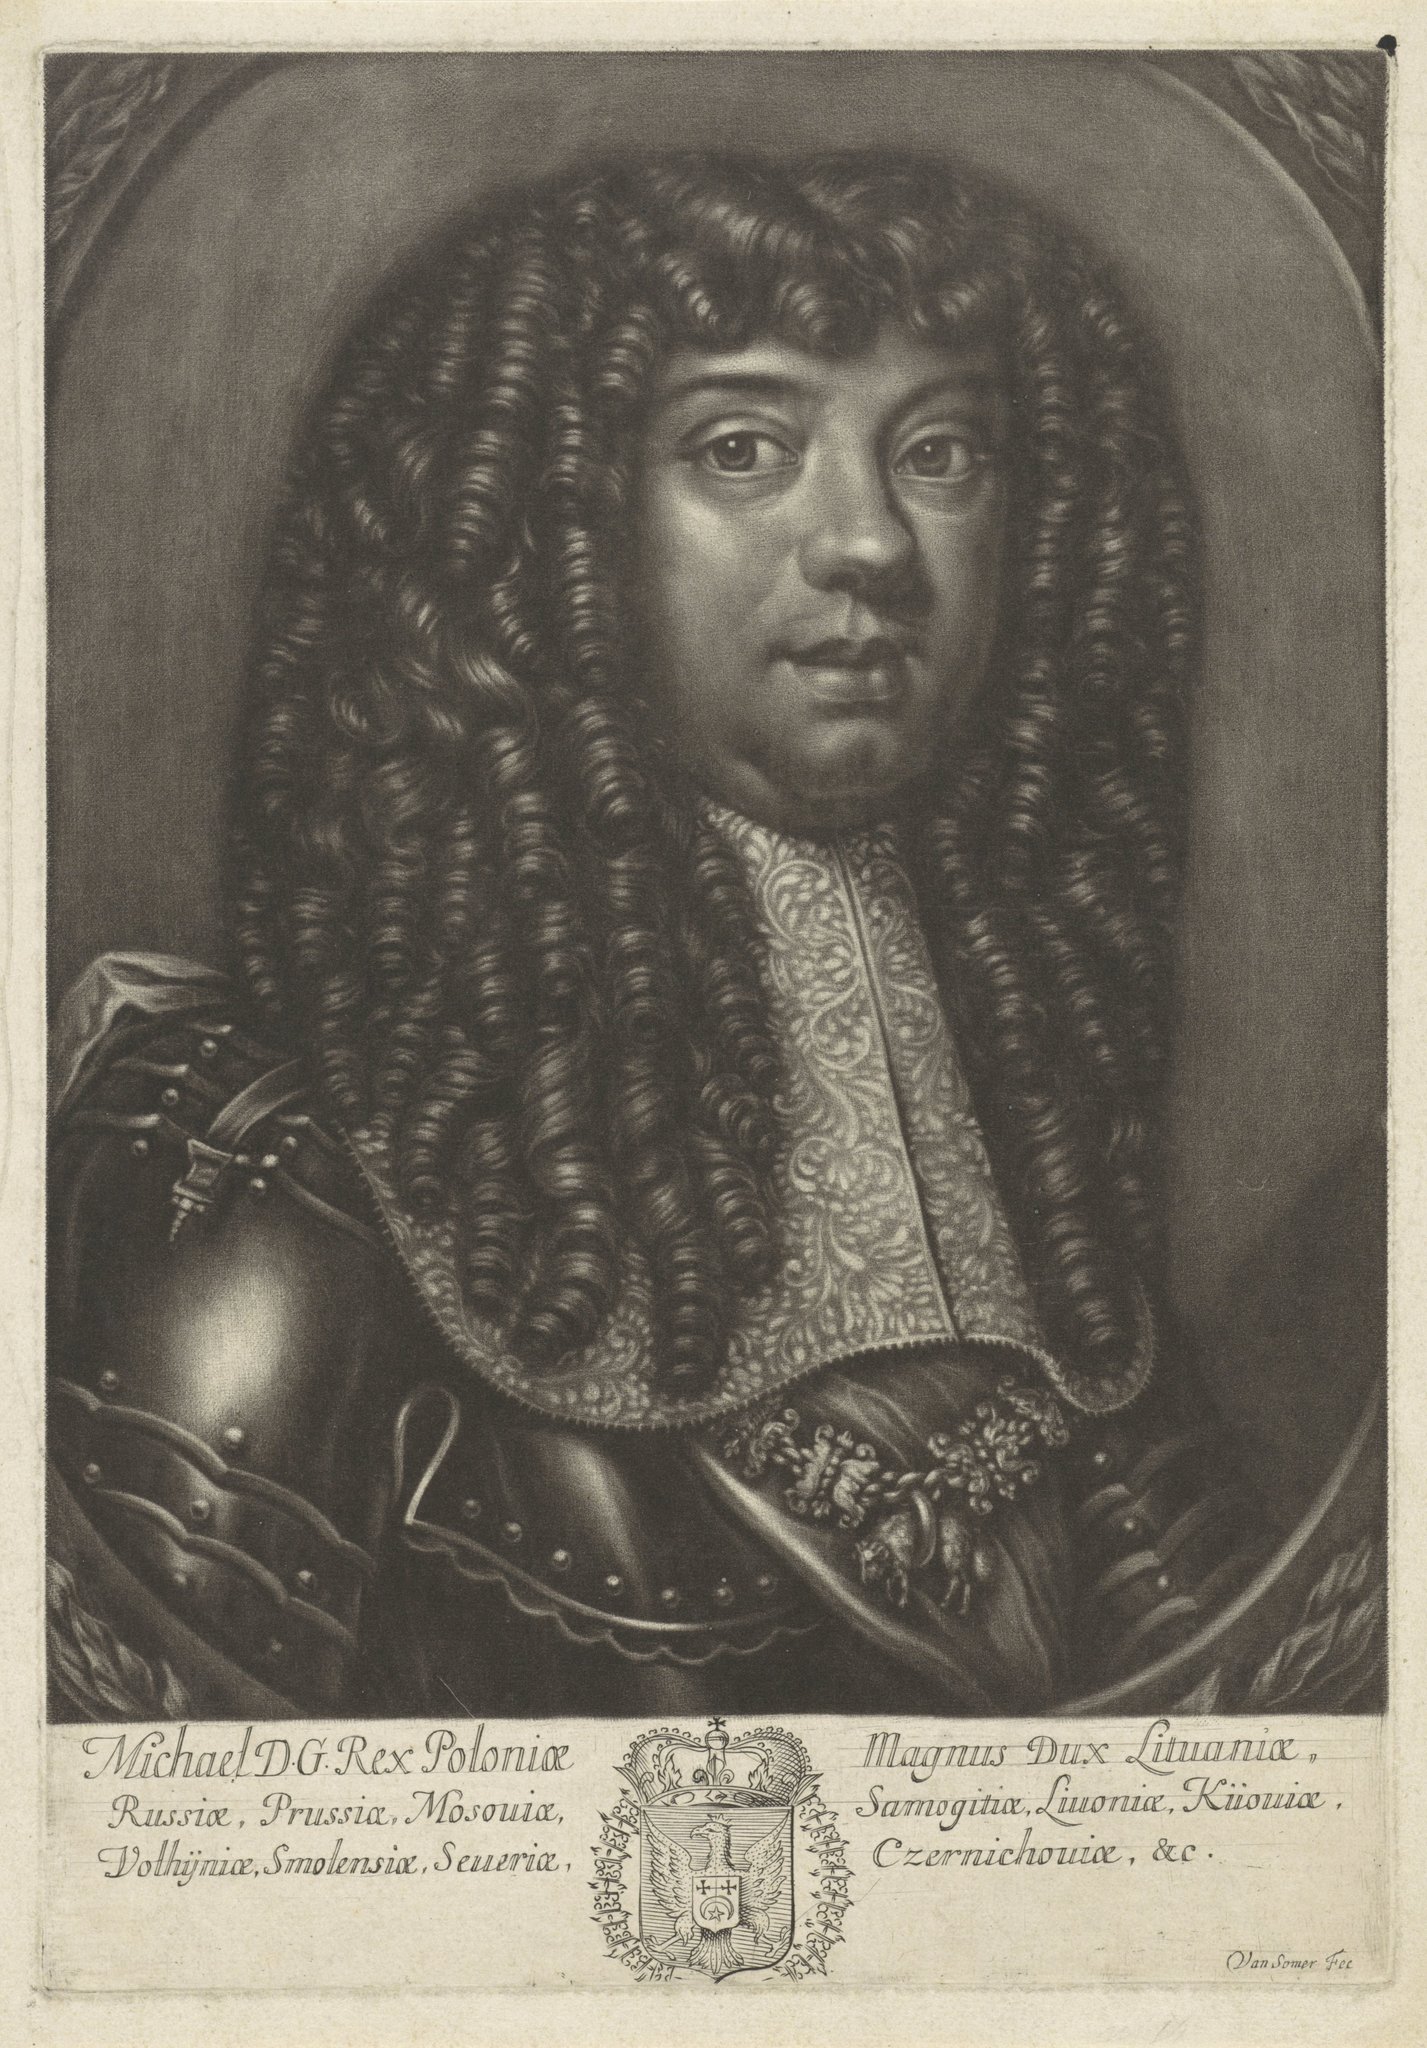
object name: print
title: Portret van Michaël Korybut Wiśniowiecki, koning van Polen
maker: jan van somer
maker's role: draughtsman, print maker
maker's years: 1645-1699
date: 1669-1700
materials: paper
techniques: engraving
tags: knighthood order of the golden fleece, wig, armorial bearing, heraldry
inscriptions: collector's mark: Lugt 2228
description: Michaël Korybut Wiśniowiecki, koning van Polen en grootvorst van Litouwen van 1669 tot 1673. Hij draagt een harnas en om zijn hals een keten waaraan het ordeteken van de Orde van het Gulden Vlies. In de marge zijn naam, titels en familiewapen.